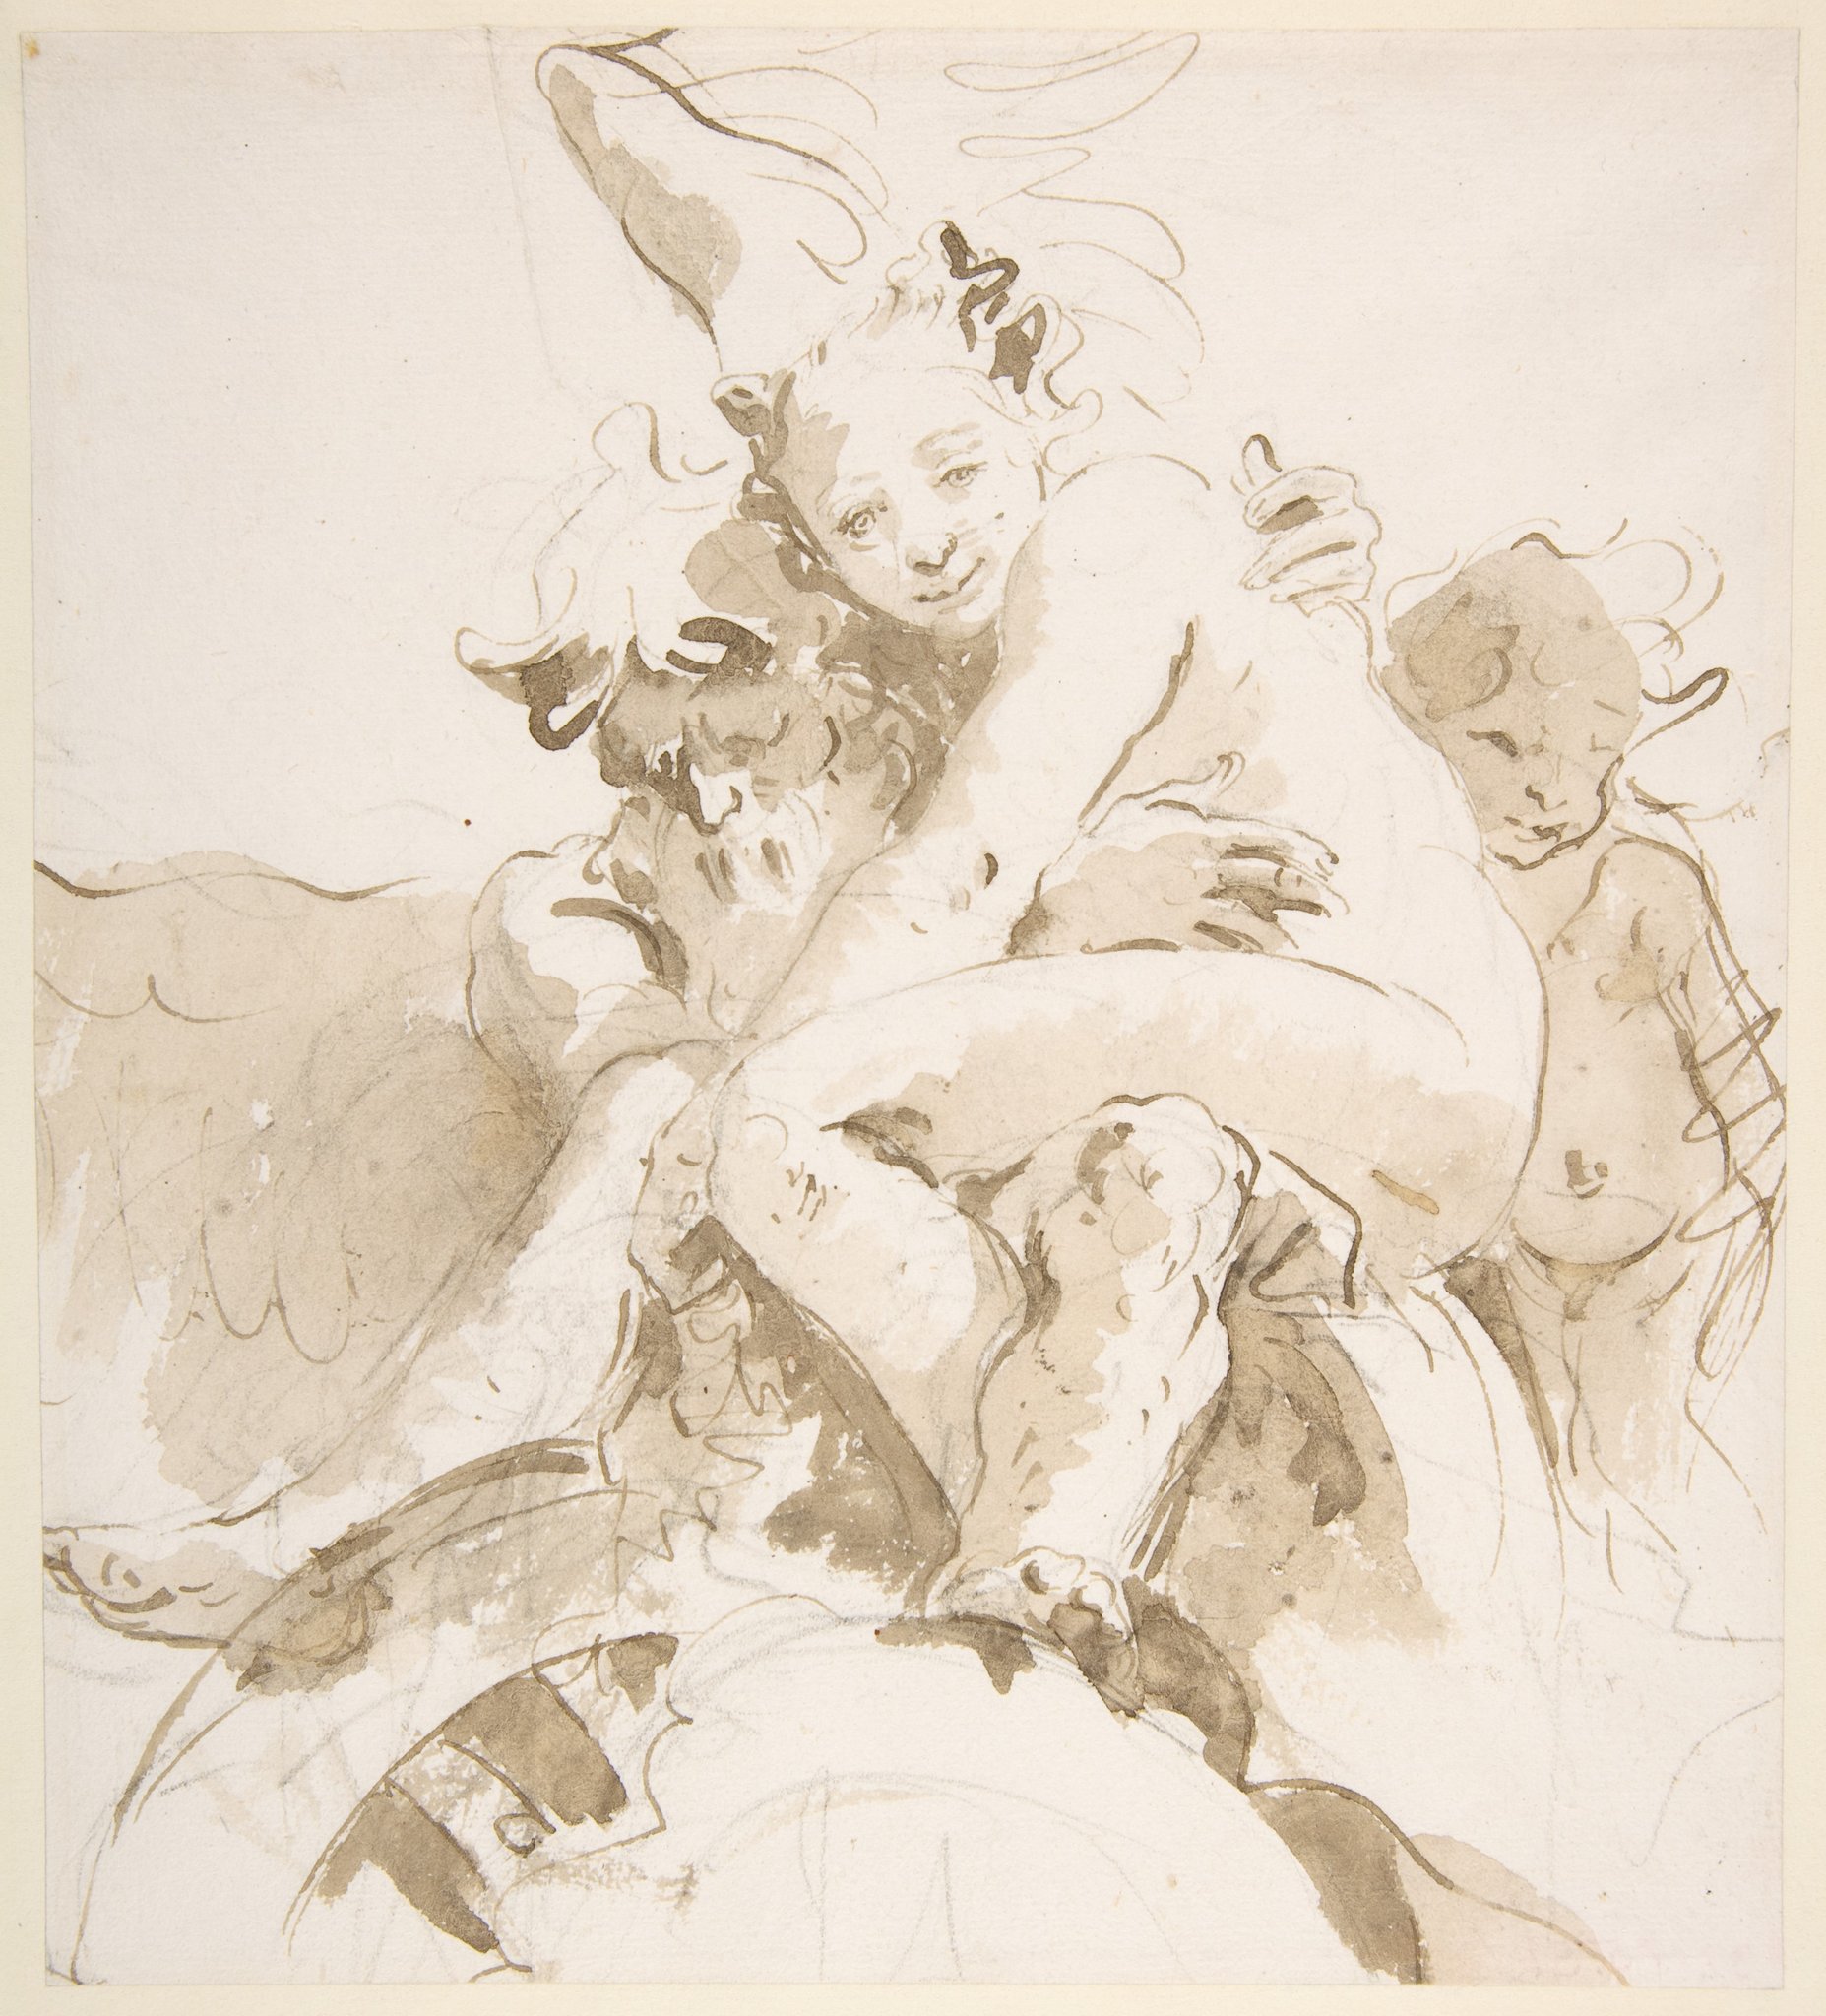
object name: drawing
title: Time Holding a Nude Woman, a Putto at Right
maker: giovanni battista tiepolo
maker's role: artist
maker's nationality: italian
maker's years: 1696-1770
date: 1696-1770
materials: chalk, ink, drawing material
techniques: brush, drawing, pen, wash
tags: female nudes,putti